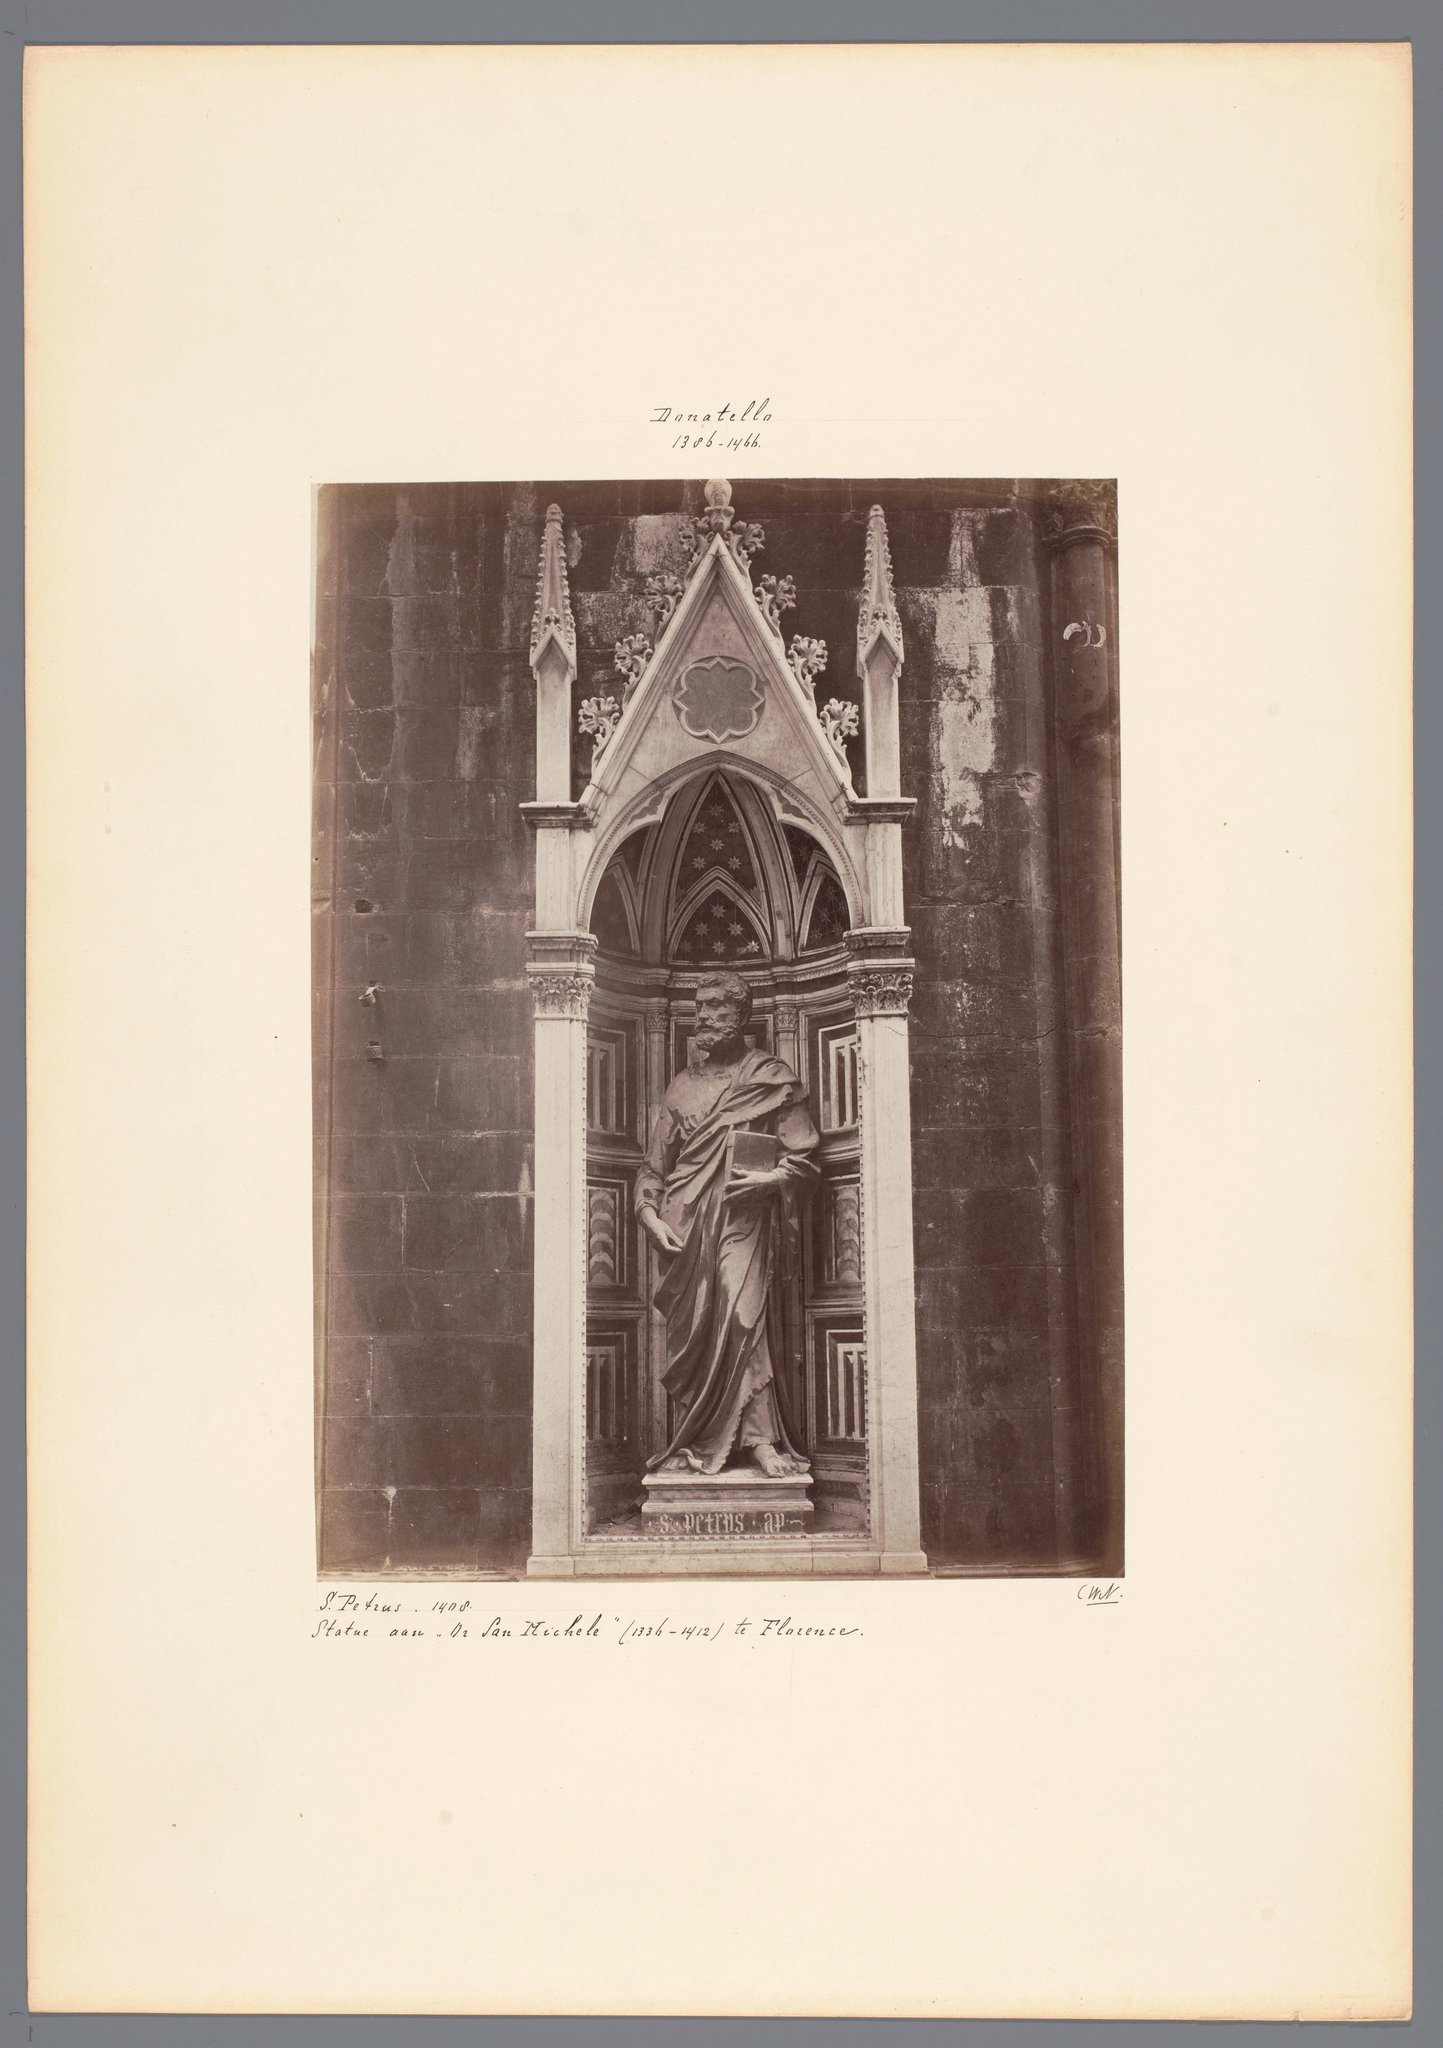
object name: photograph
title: Donatello. S. Petrus. 1408. Statue aan ,, Or San Michele" (1336-1412) te Florence.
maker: Anonymous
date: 1875-1900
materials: cardboard, photographic support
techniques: albumen print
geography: florence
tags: life and acts of peter, monument, statue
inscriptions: collector's mark: ‘KUNSTNIJVERHEIDSCHOOL QUELLINUS AMSTERDAM FRANS HALSSTRAAT 14.’, inscription: ‘CWN.’, collector's mark: ‘INSTITUUT VOOR KUNST-NIJVERHEIDSONDERWIJS GABRIËL METSUSTRAAT No. 16 AMSTERDAM’, number: ‘1386-1466’